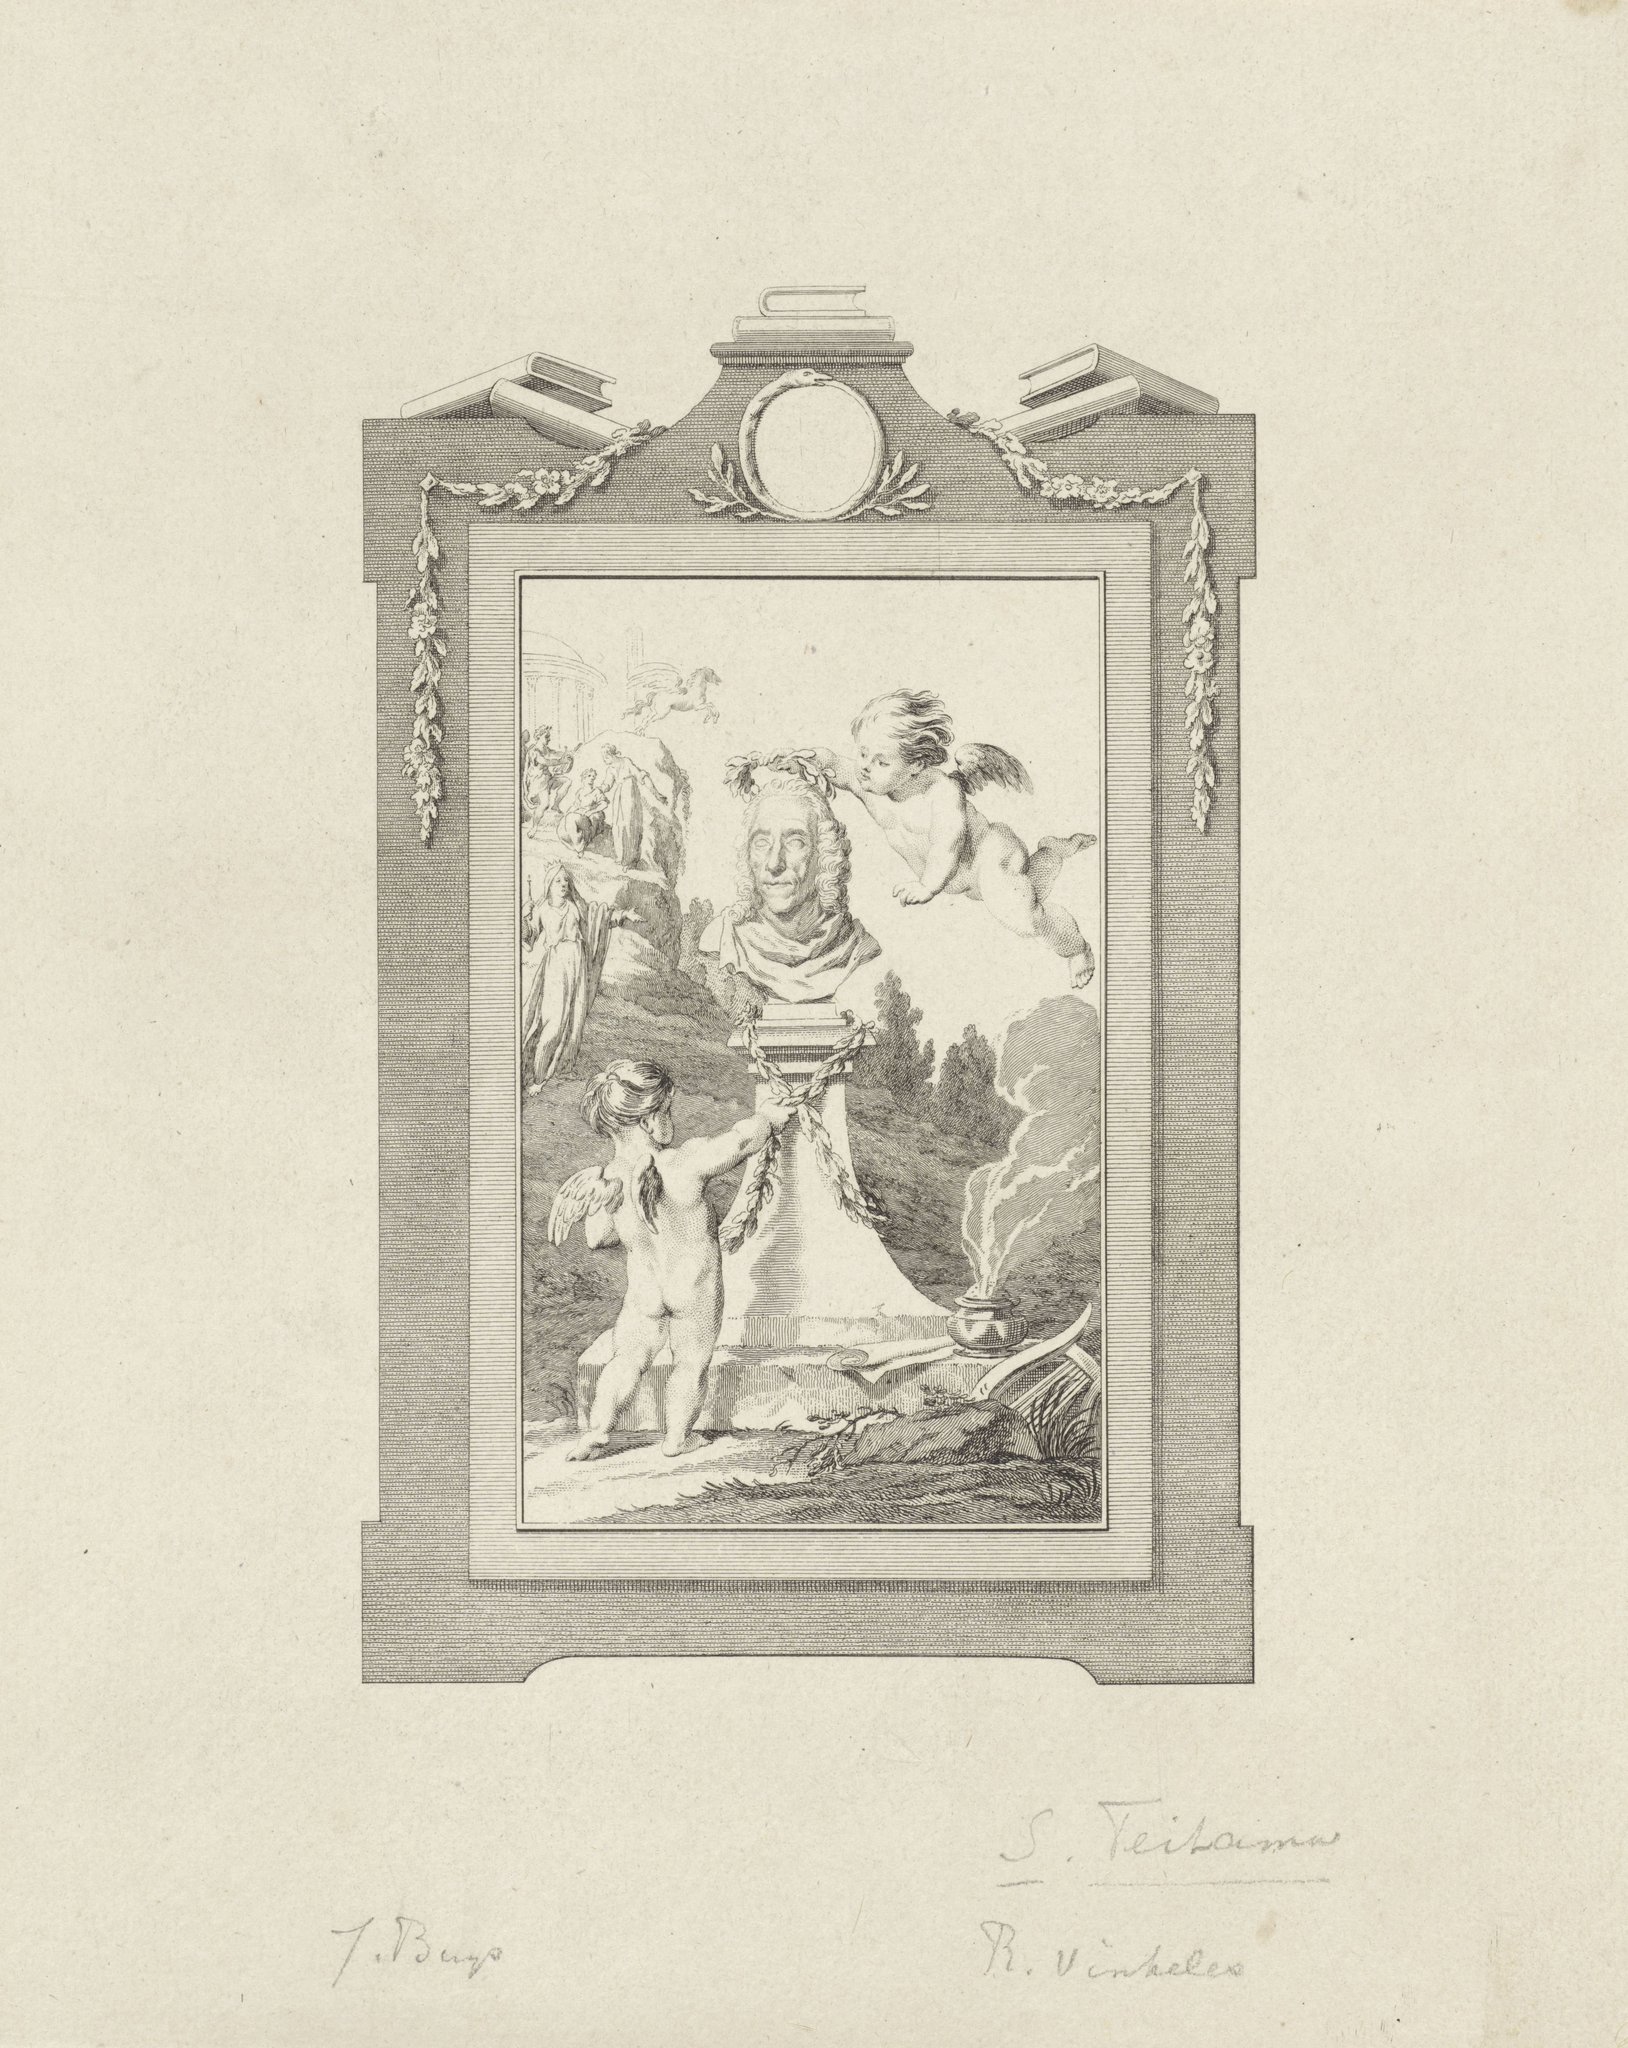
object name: print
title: Studio Fovetur Ingenium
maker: reinier vinkeles (i)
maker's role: draughtsman, print maker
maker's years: 1741-1816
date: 1773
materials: paper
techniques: etching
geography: amsterdam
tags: sybrand feitama (ii), honouring the artist with laurel wreath, parnassus, sacred to apollo musagetes, smoking pot as symbol of 'vanitas'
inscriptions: collector's mark: Lugt 2228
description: Twee putto lauweren het borstbeeld van de kunstenaar Sybrand Feitama, dat op een sokkel staat. Op de grond staat een rokende pot, dat symbool staat voor zijn overlijden. Ook ligt er een lier en een rol papier. Links Apollo, de muzen en Pegasus op de Parnassus. Bovenaan op de omlijsting boeken en het eeuwigheidssymbool de Ouroboros.